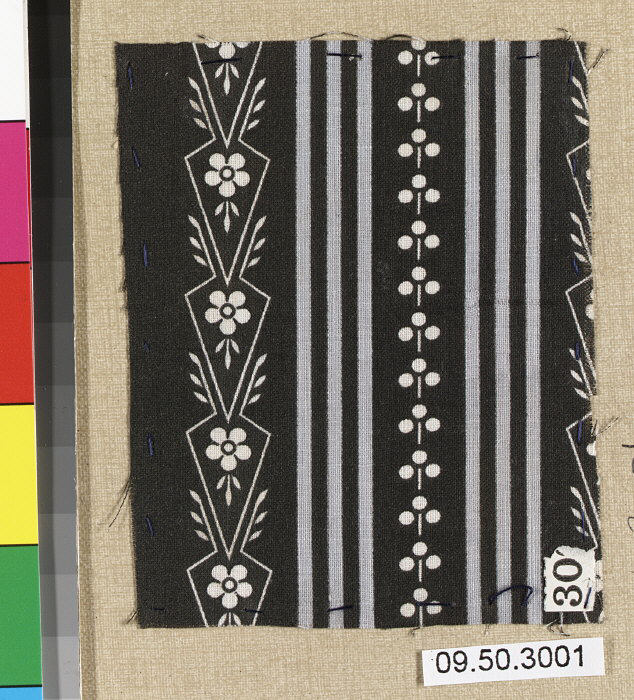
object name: piece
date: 1801-1900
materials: cotton